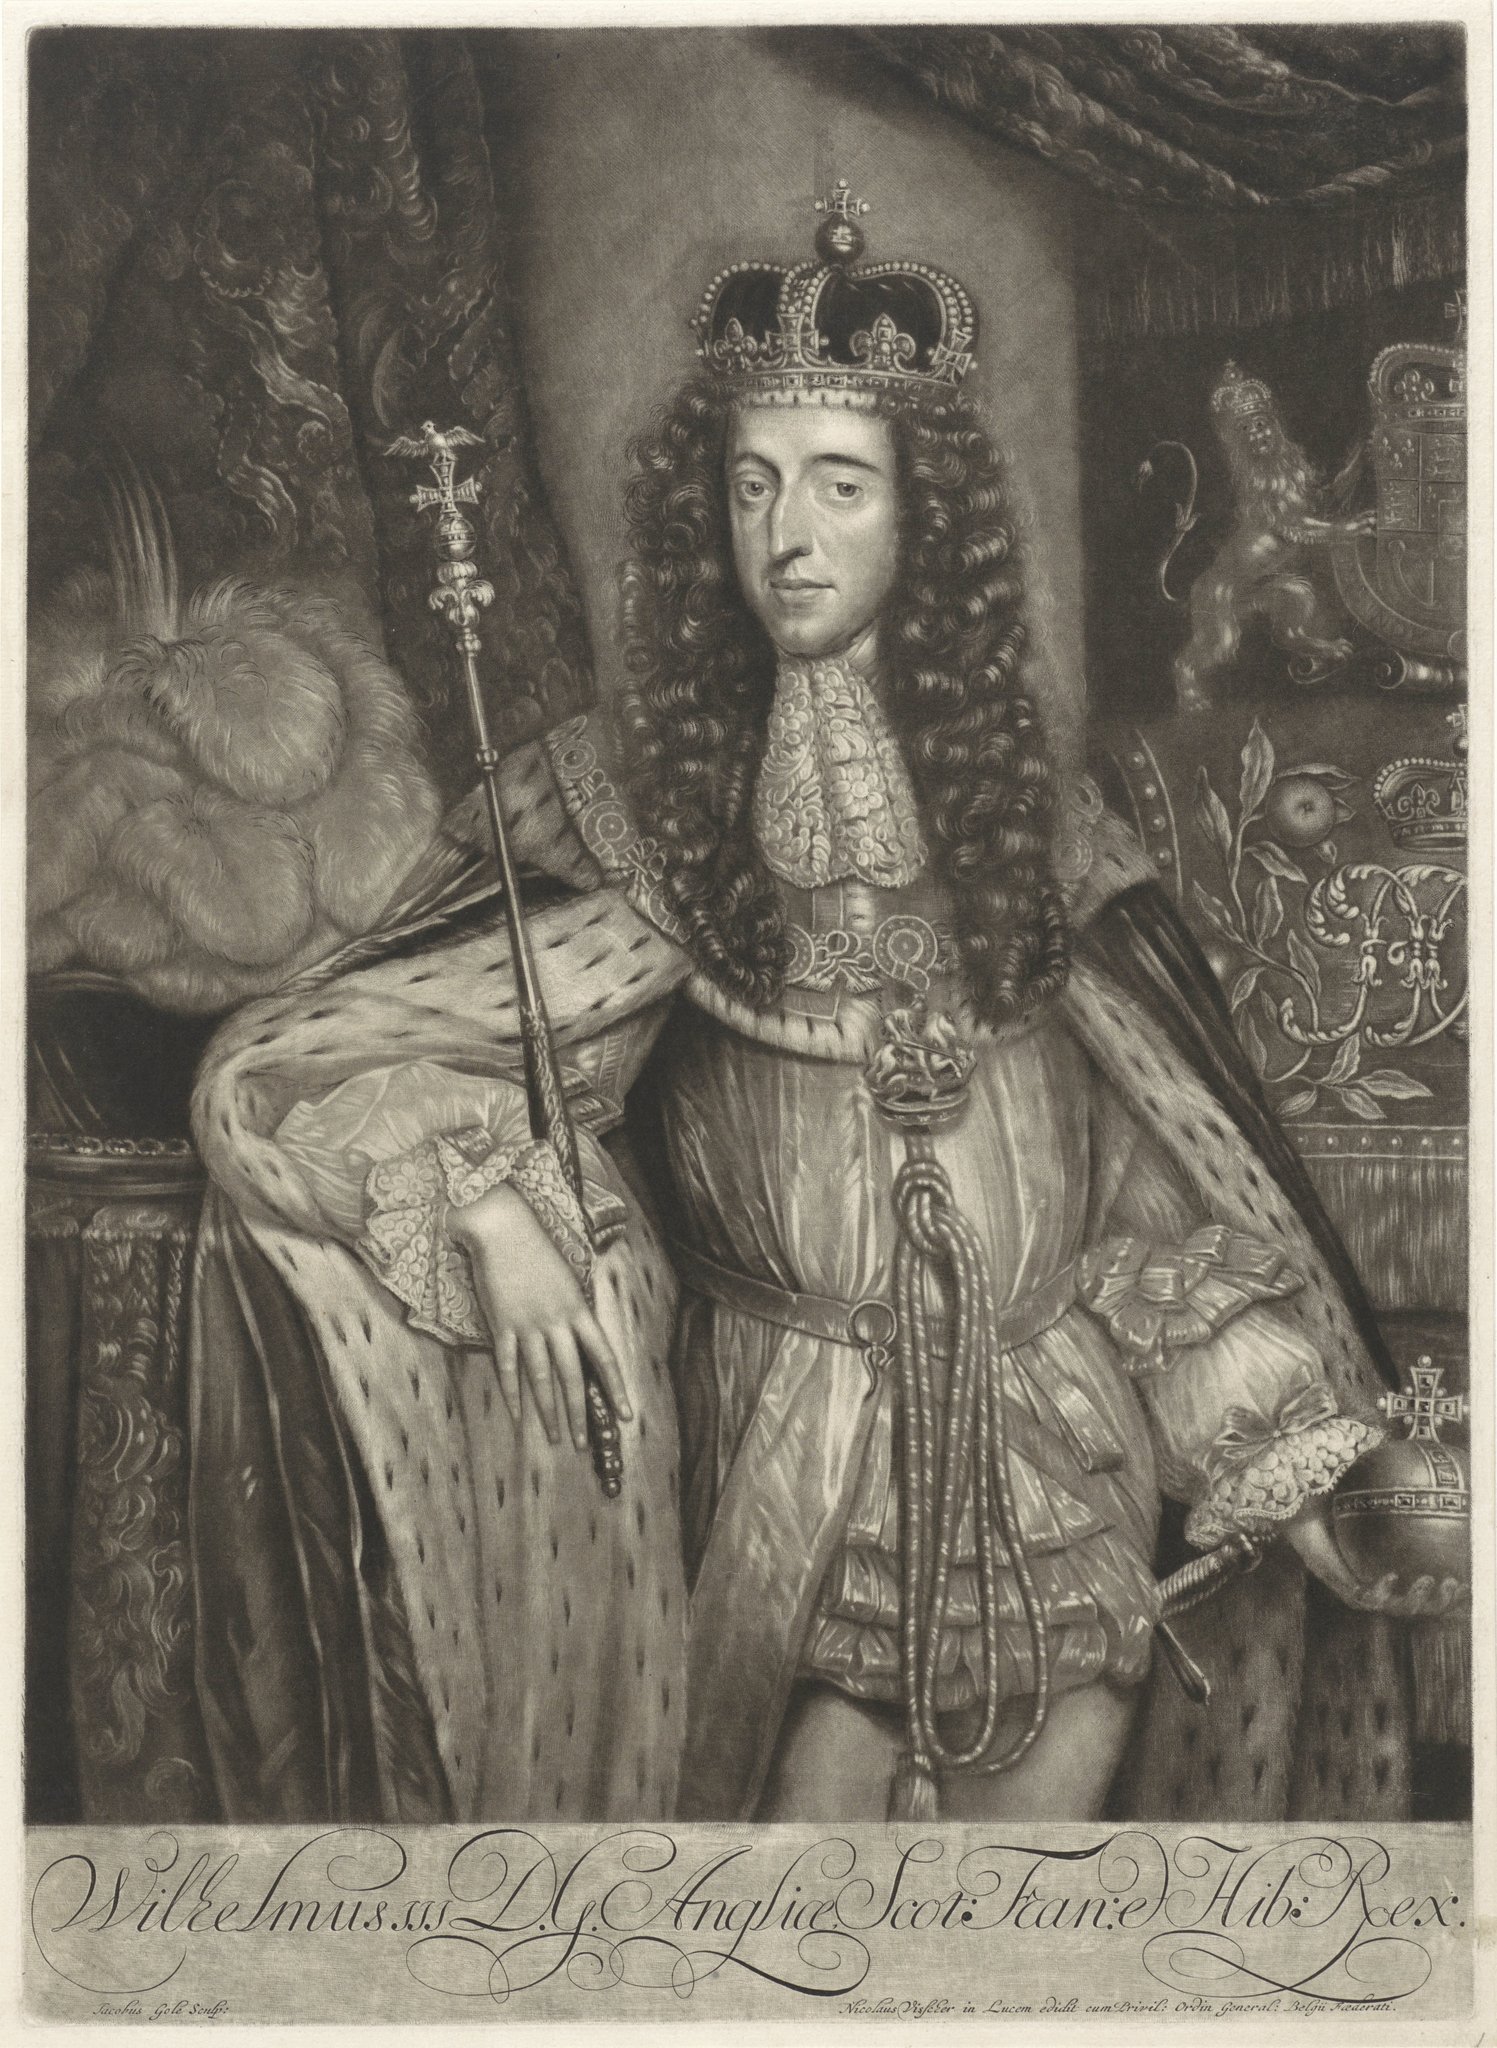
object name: print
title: Portret van Willem III, prins van Oranje-Nassau, koning van Engeland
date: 1689-1724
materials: paper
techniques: engraving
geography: amsterdam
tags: the hague, william iii (prince of orange and king of england, scotland, and ireland), knighthood order, armorial bearing, heraldry, insignia and symbols of sovereignty (crown, diadem, sceptre, orb, seal, standard, cloak, pectoral)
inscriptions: collector's mark: Lugt 2259a, collector's mark: Lugt 2166, collector's mark: Lugt 2760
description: Willem III, prins van Oranje, stadhouder en sedert 1689 koning van Engeland. Hij draagt de kroon en een kroningsmantel en om de hals een ordeketting van de Orde van de Kousenband. In de handen een scepter en de rijksappel. Achter hem een troon met zijn gekroonde familiewapen.